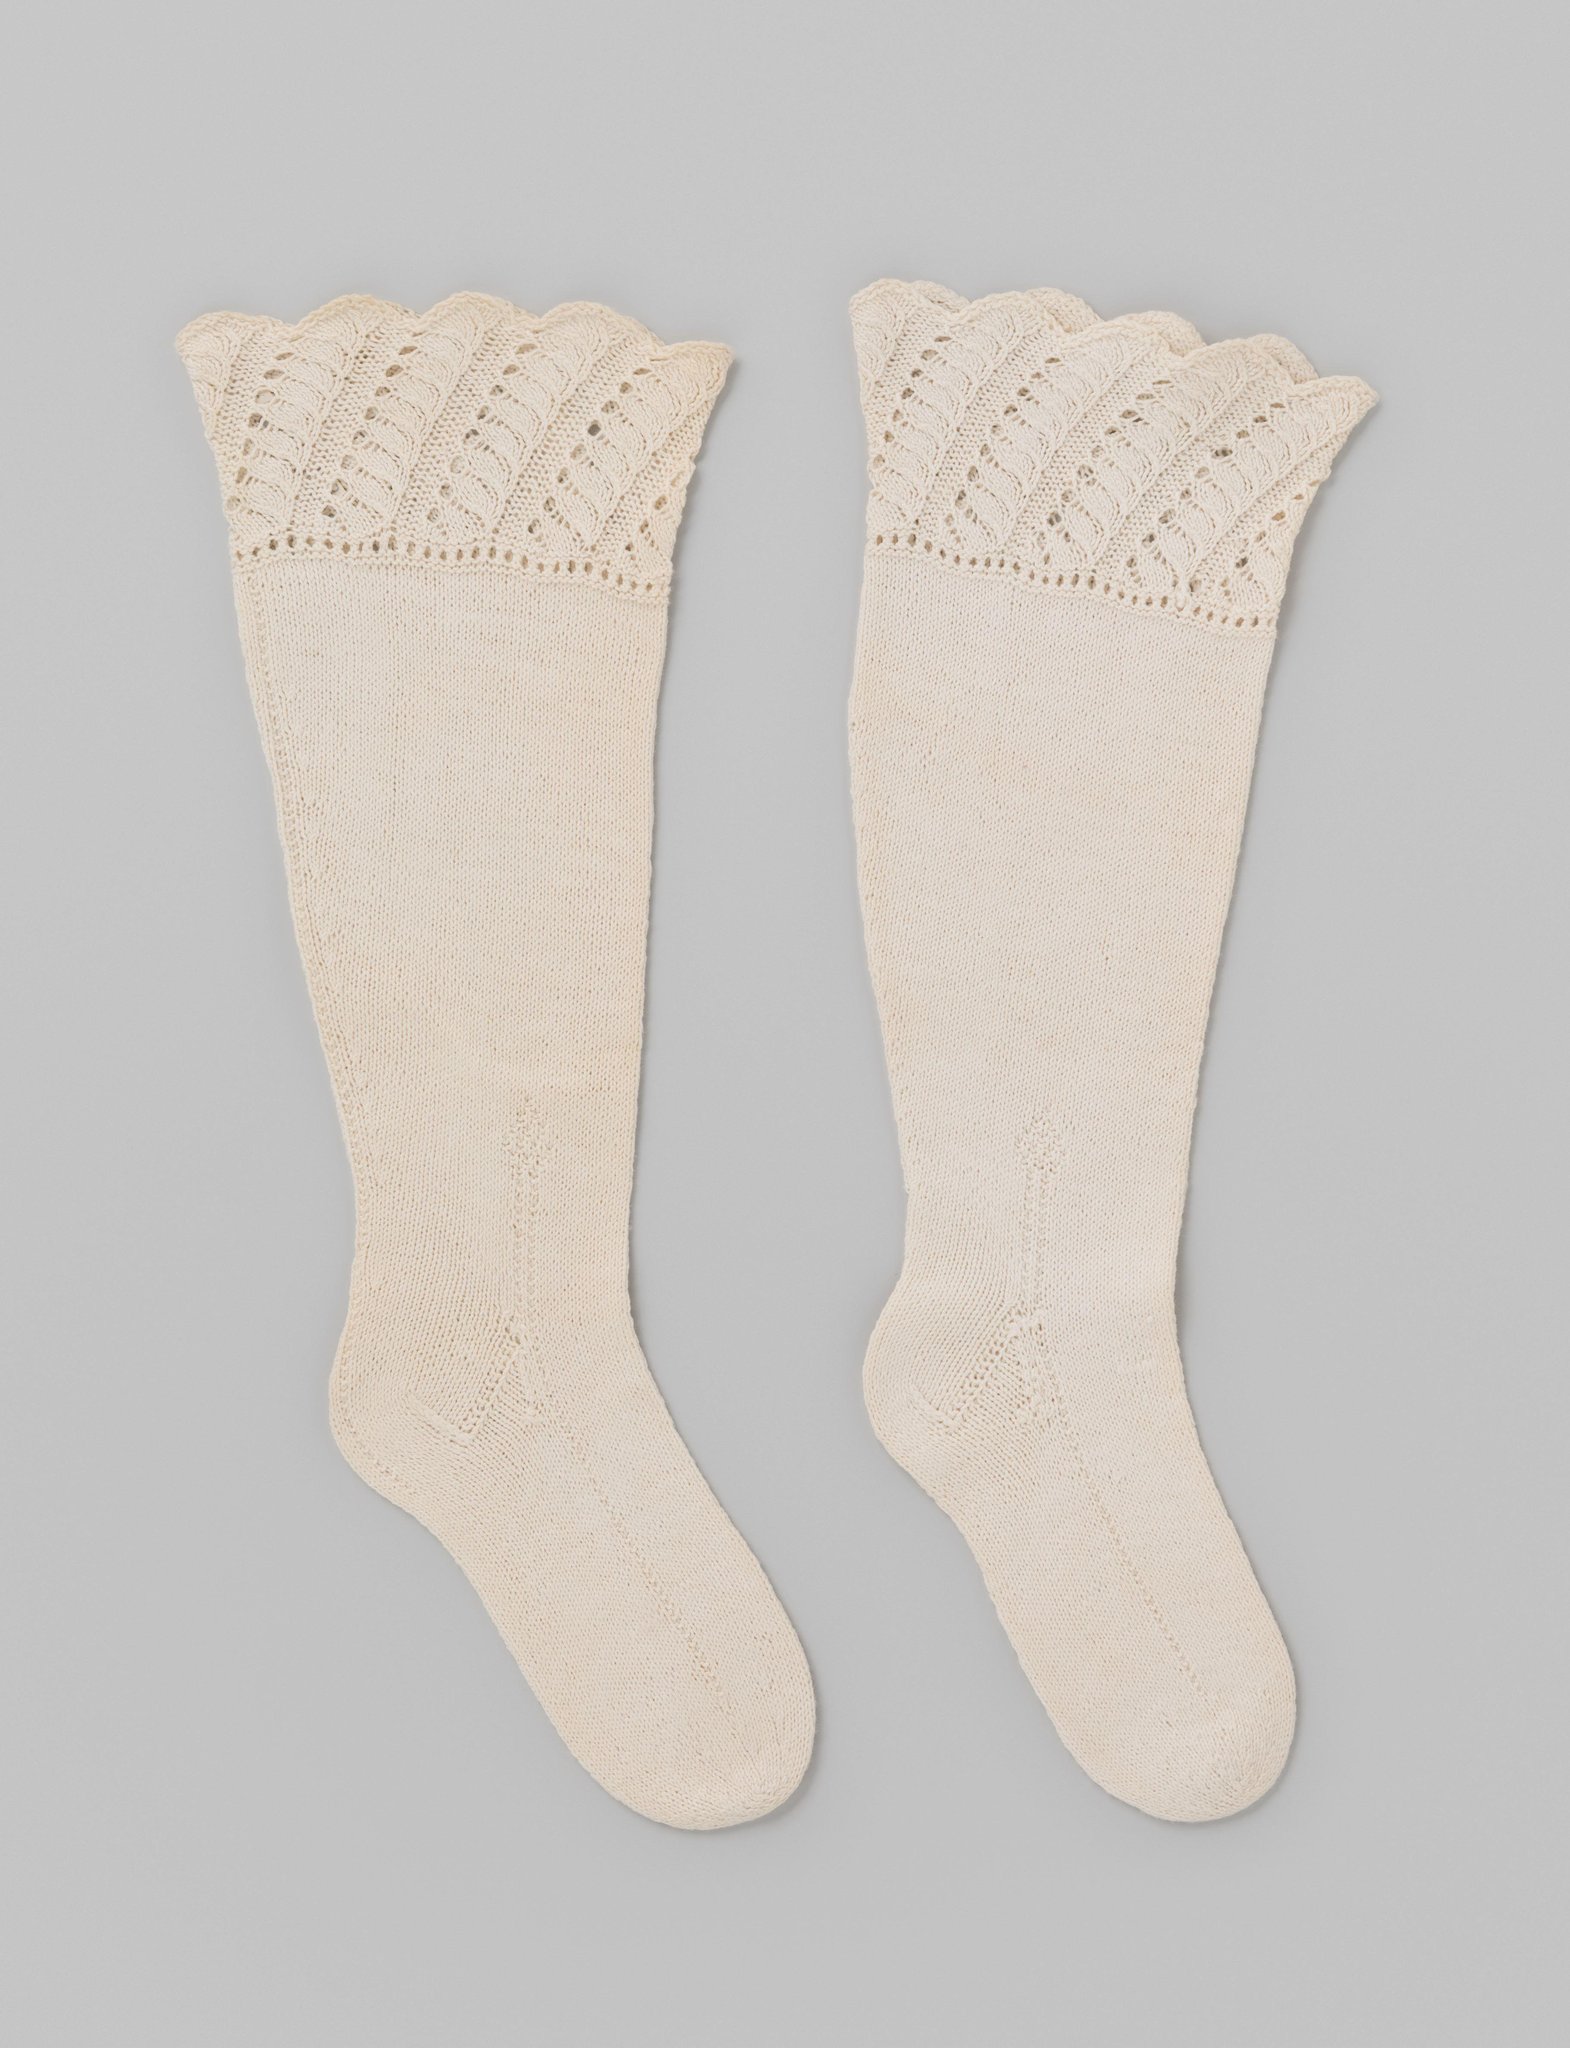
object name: stocking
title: Kous van gebreid katoen met pijlversiering op de klink, geschulpte boord met schuine rijen van kabelsteek, kindermaat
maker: Anonymous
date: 1800-1900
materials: cotton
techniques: knitting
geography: netherlands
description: Kous van gebreid katoen met gebreiede pijlversiering op de klink, geschulpte boord met schuine rijen van kabelsteek. Kindermaat.